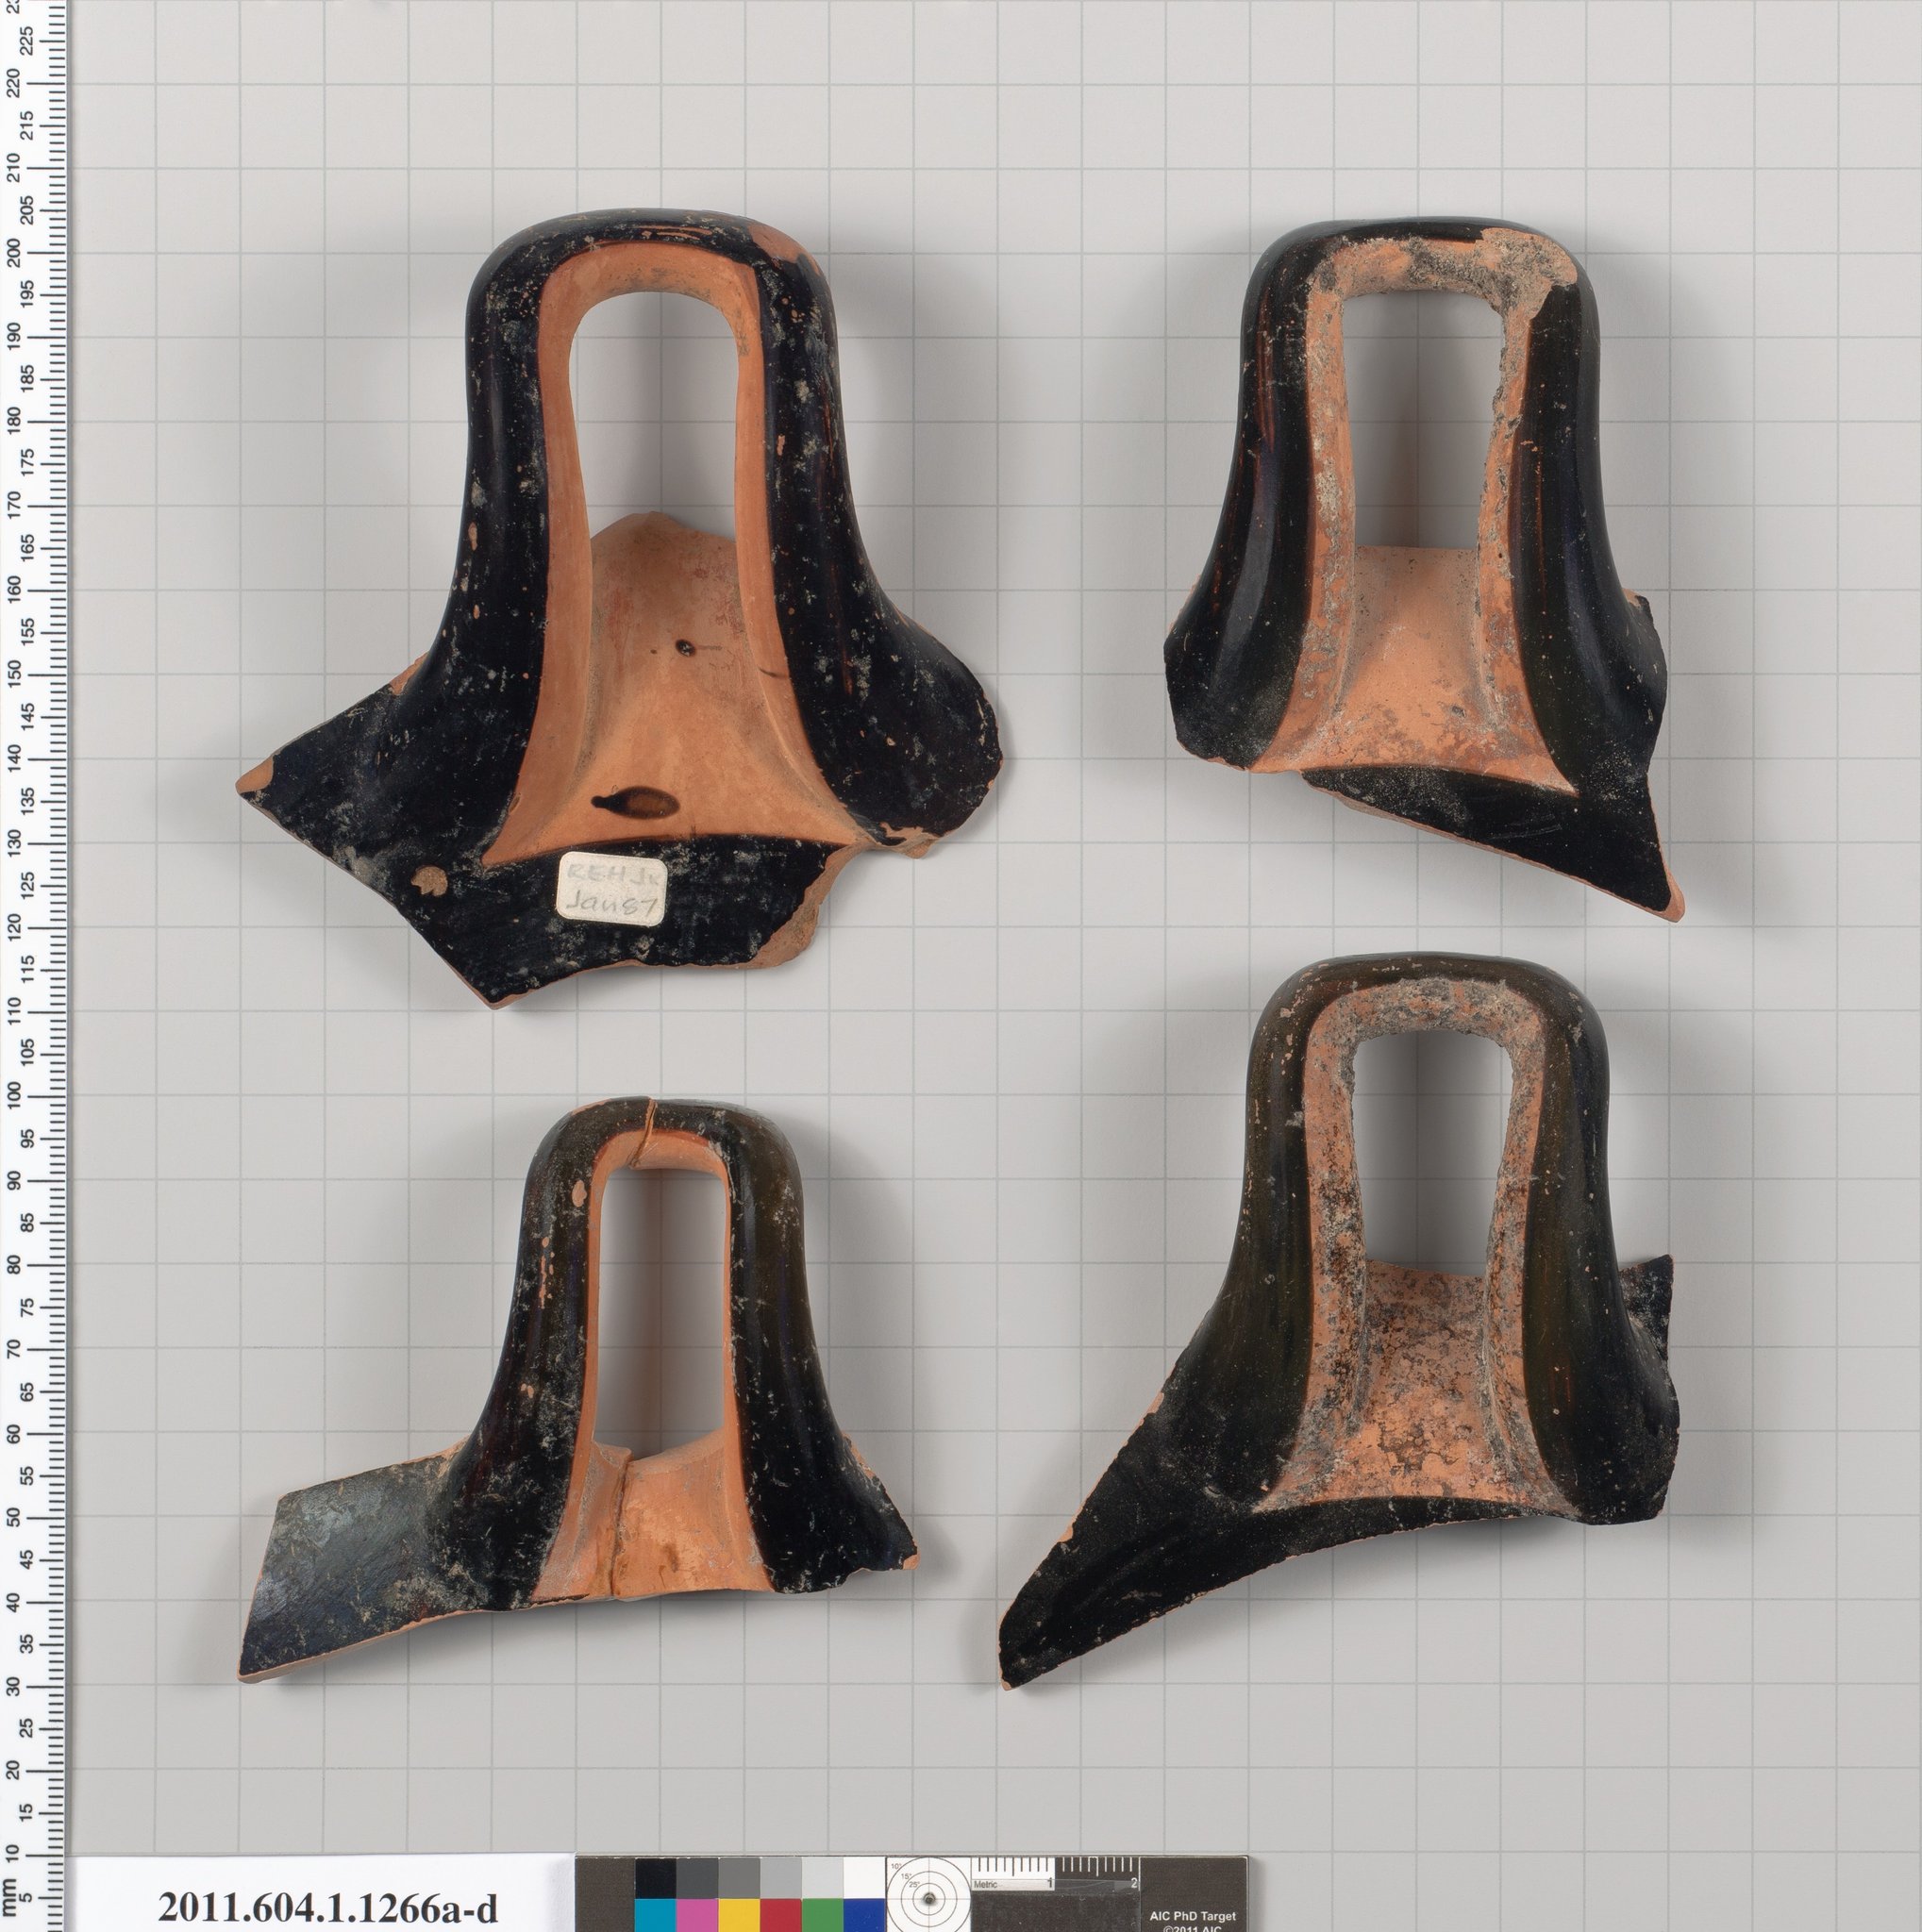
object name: kylix fragment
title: Terracotta fragments of kylikes (drinking cups)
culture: greek, attic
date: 500-401 BCE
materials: terracotta